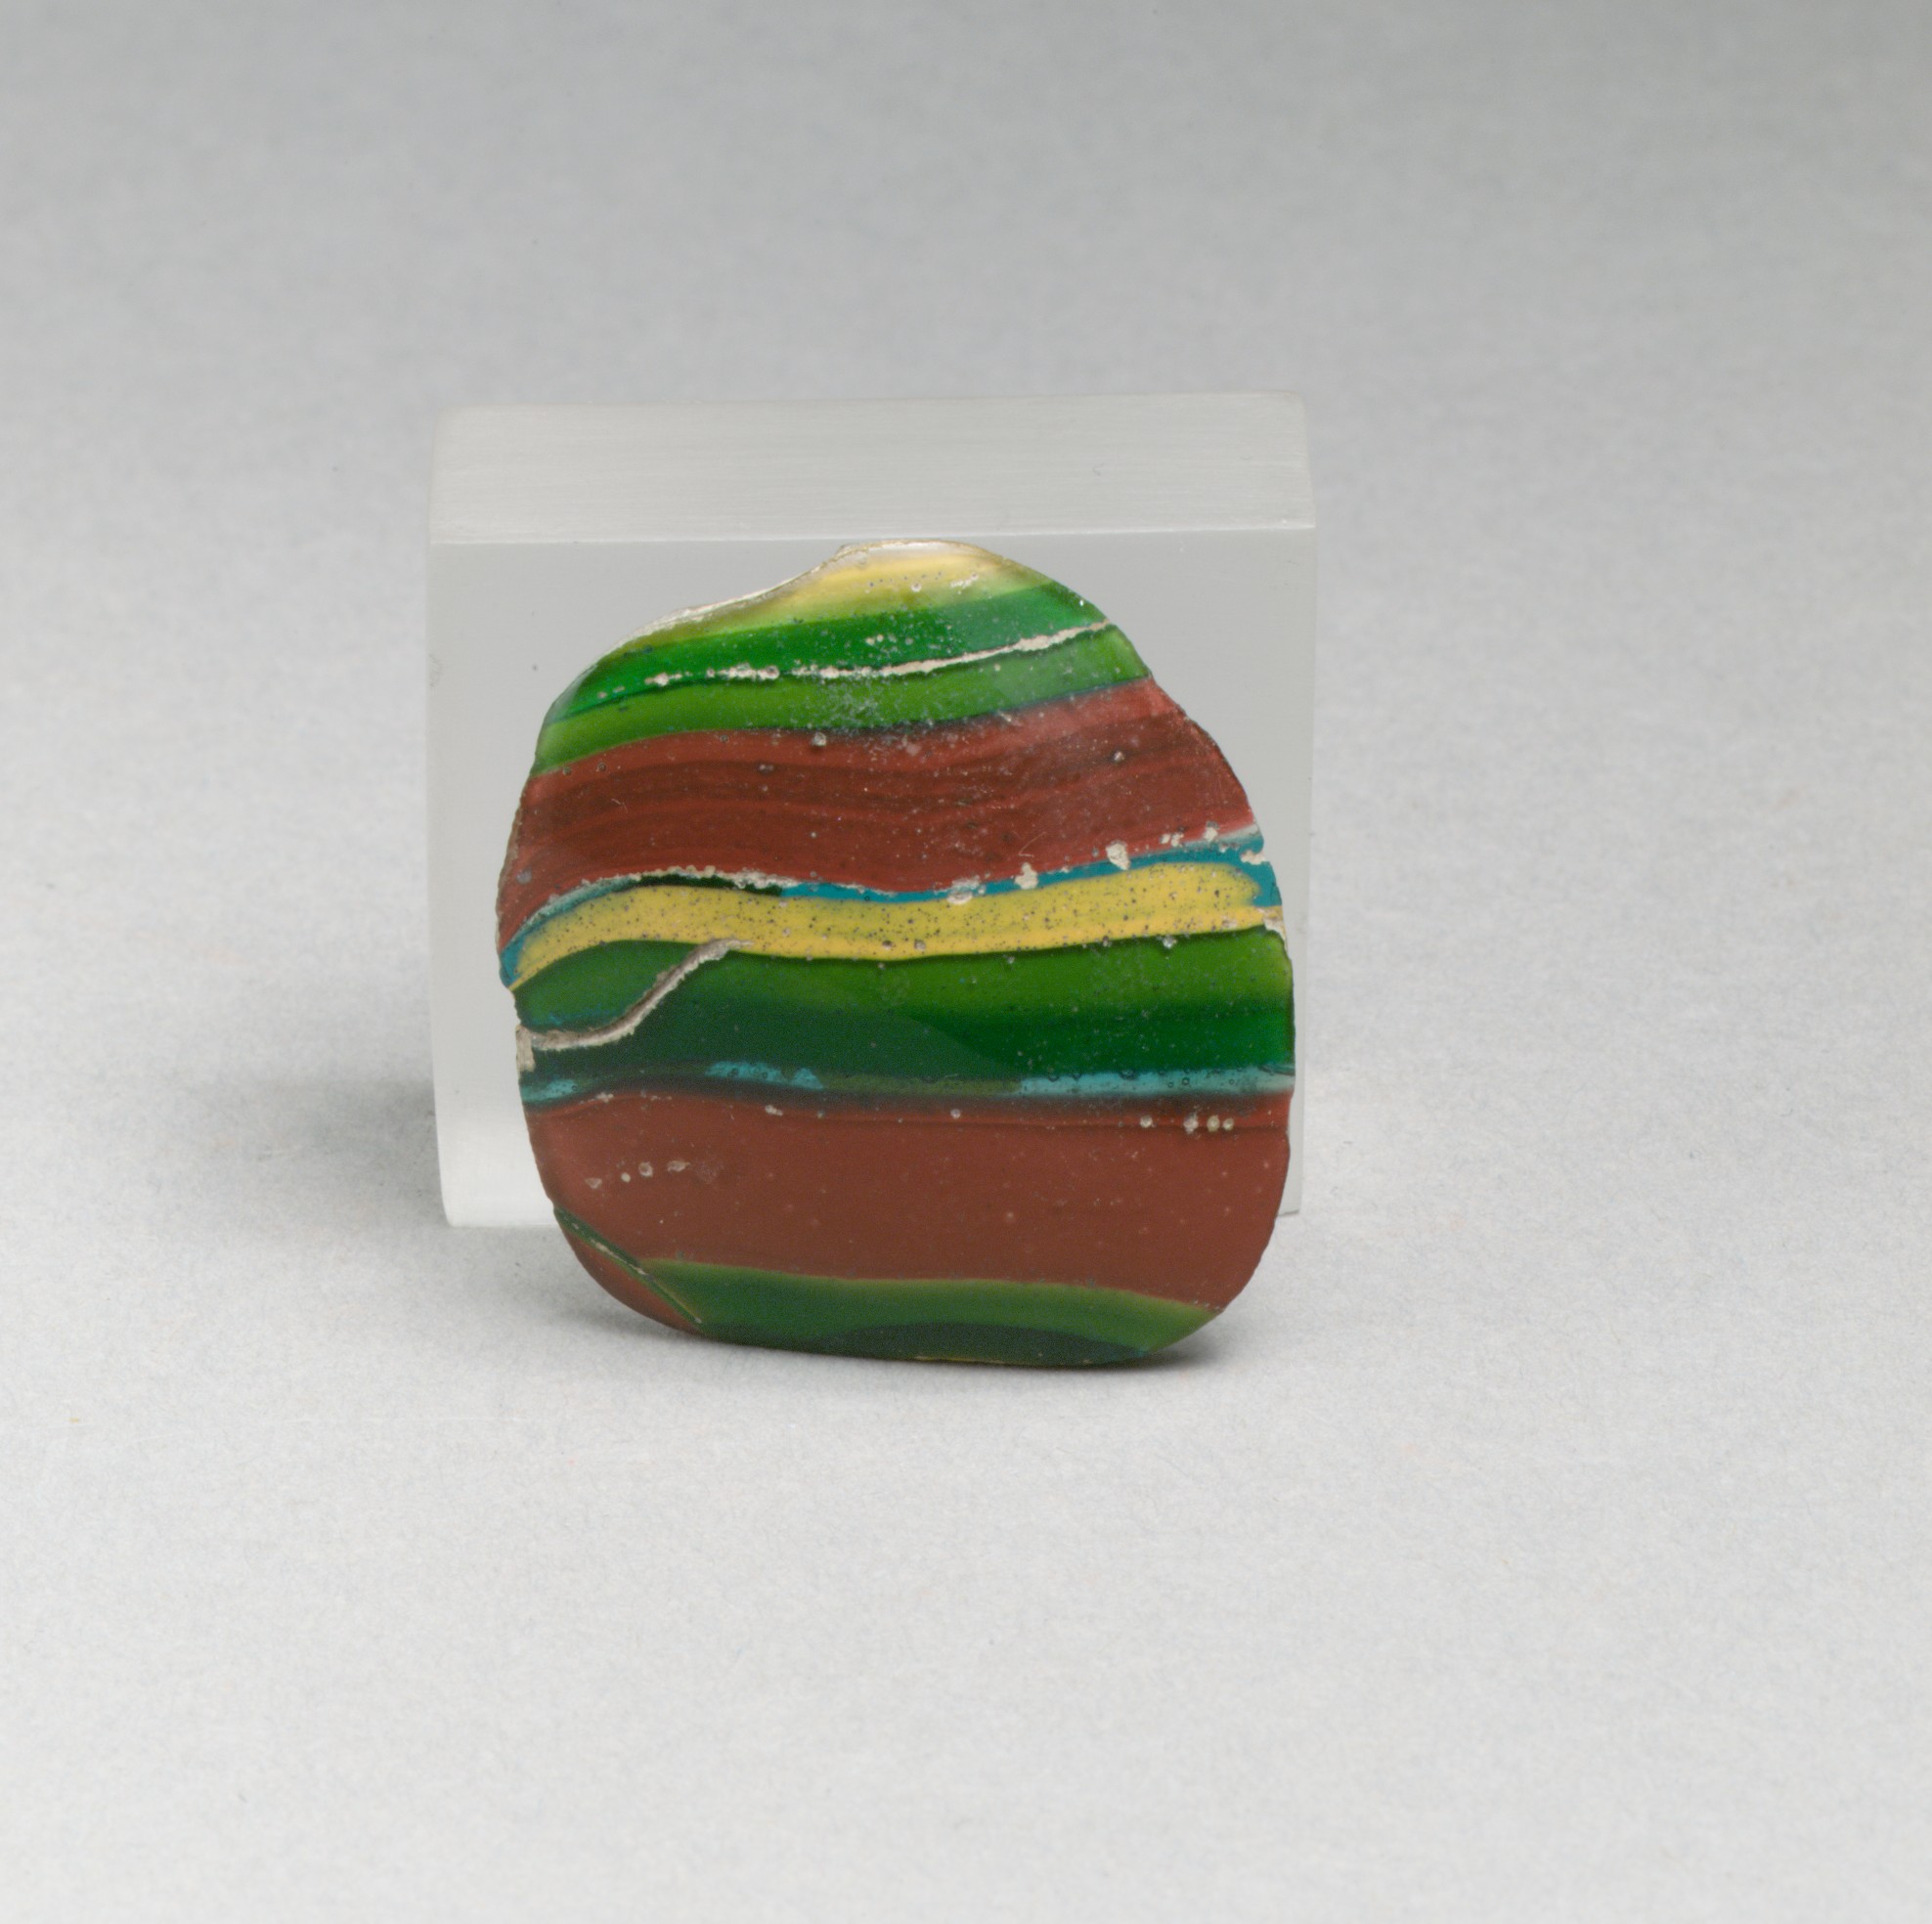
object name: fragment, mosaic bowl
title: Glass striped mosaic bowl fragment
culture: roman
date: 34 BCE-33 CE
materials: glass